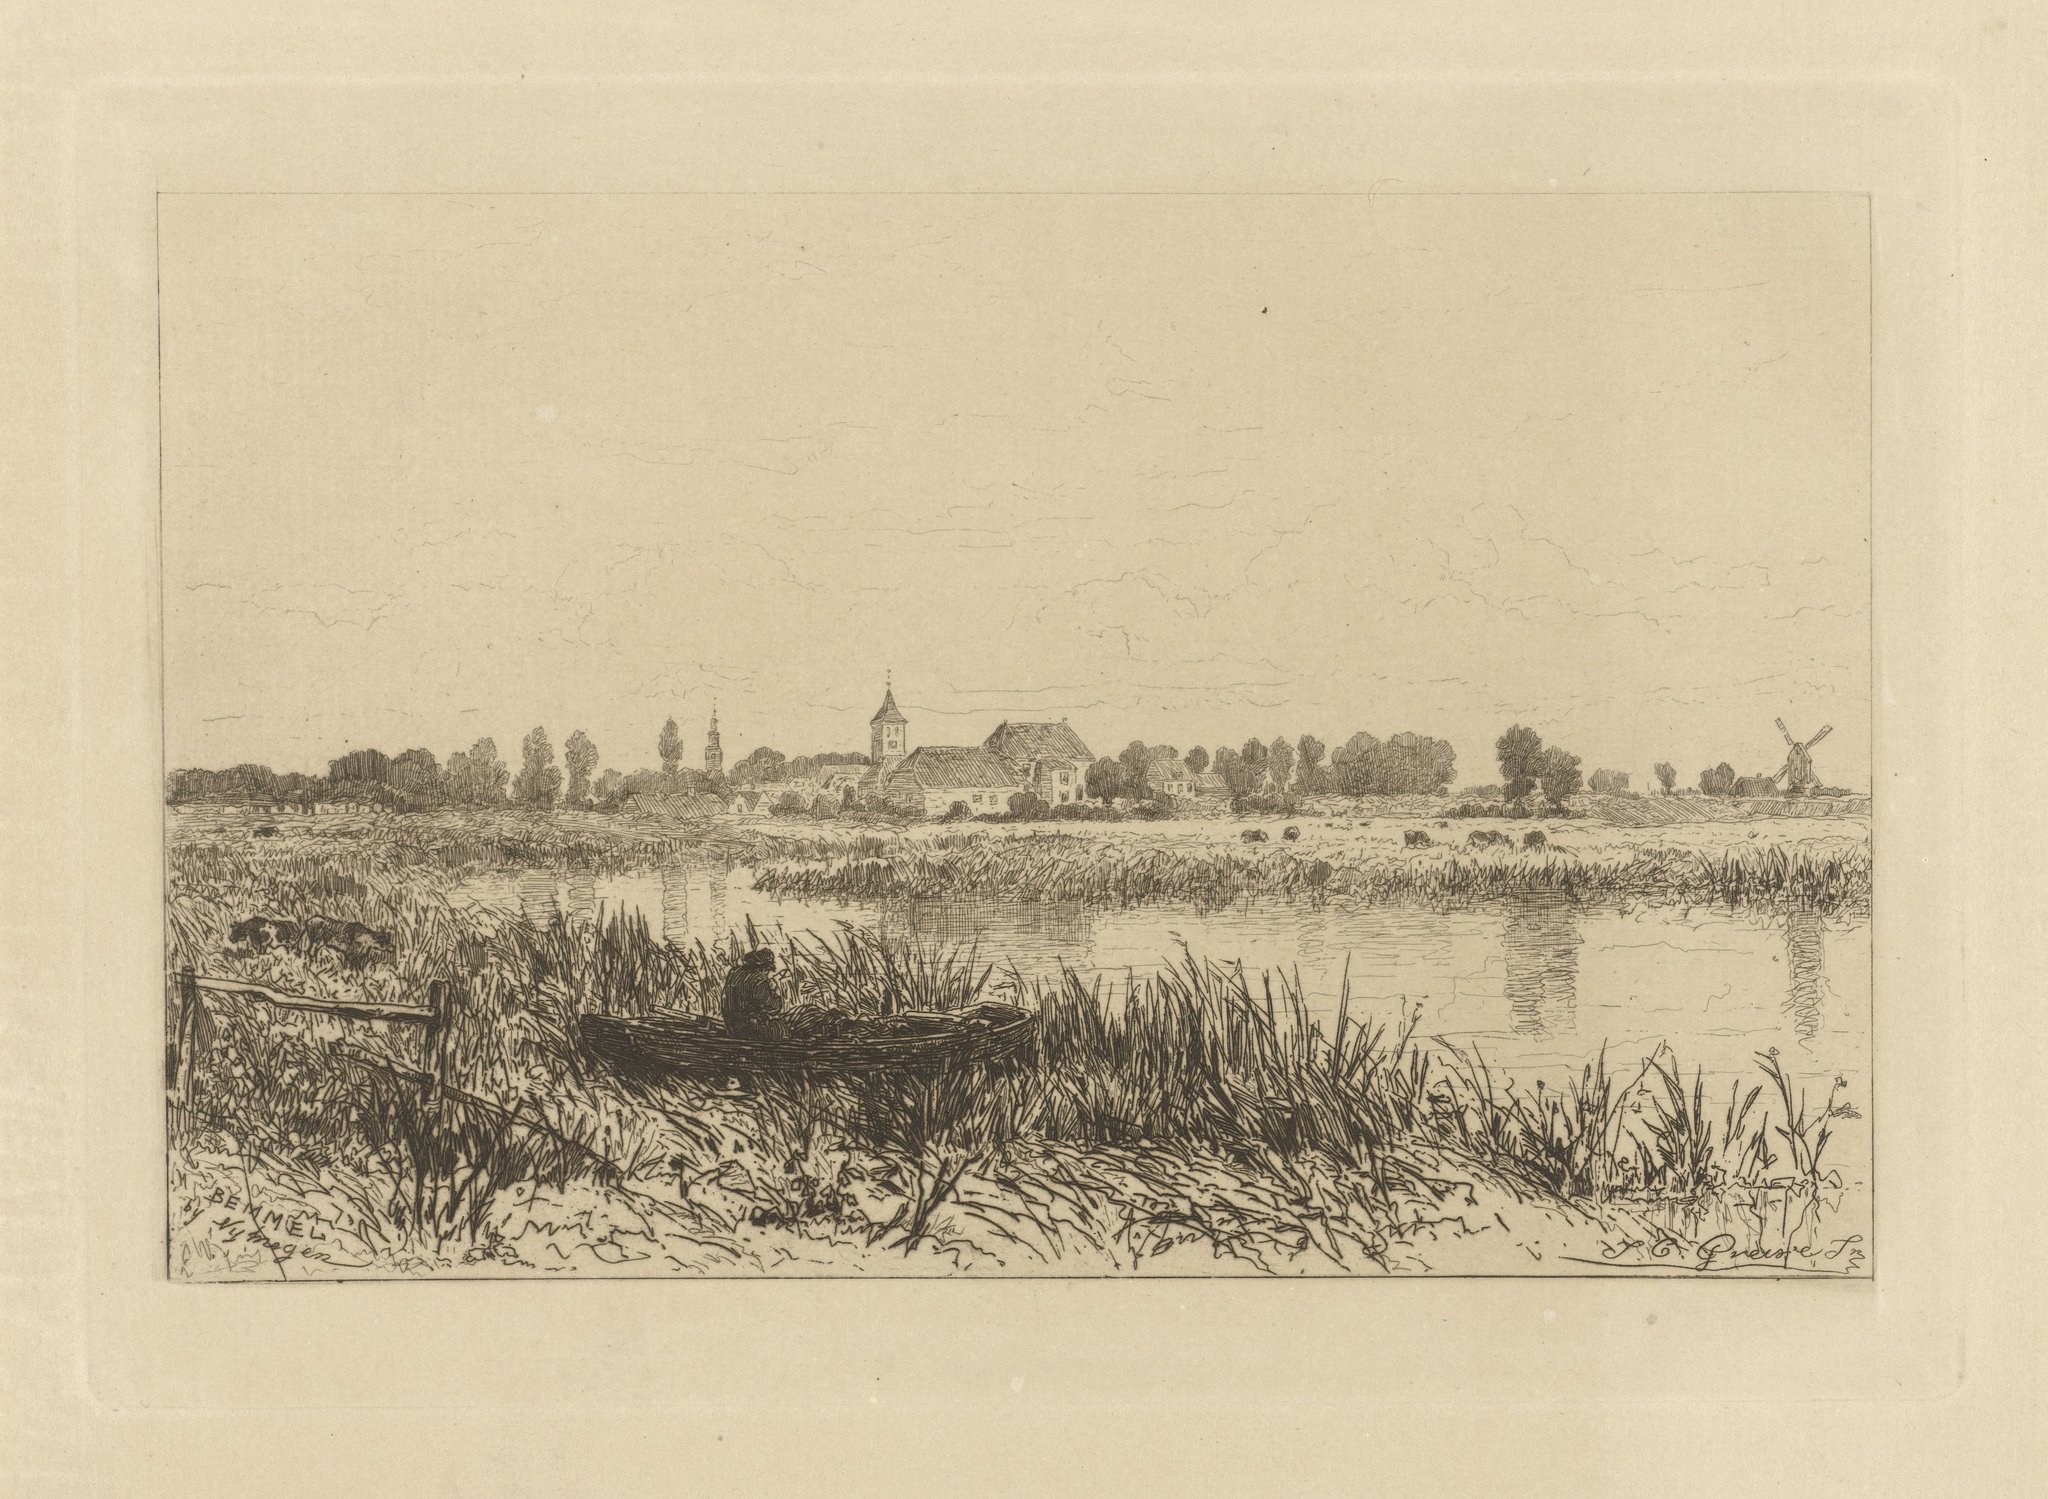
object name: print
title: Gezicht op een rivier nabij Bemmel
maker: johan conrad greive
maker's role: draughtsman, painter, print maker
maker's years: 1837-1891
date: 1847-1891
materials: paper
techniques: etching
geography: amsterdam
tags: river (+ landscape with figures, staffage)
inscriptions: collector's mark: Lugt 2228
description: Een rivier met op de achtergrond het dorpje Bemmel.